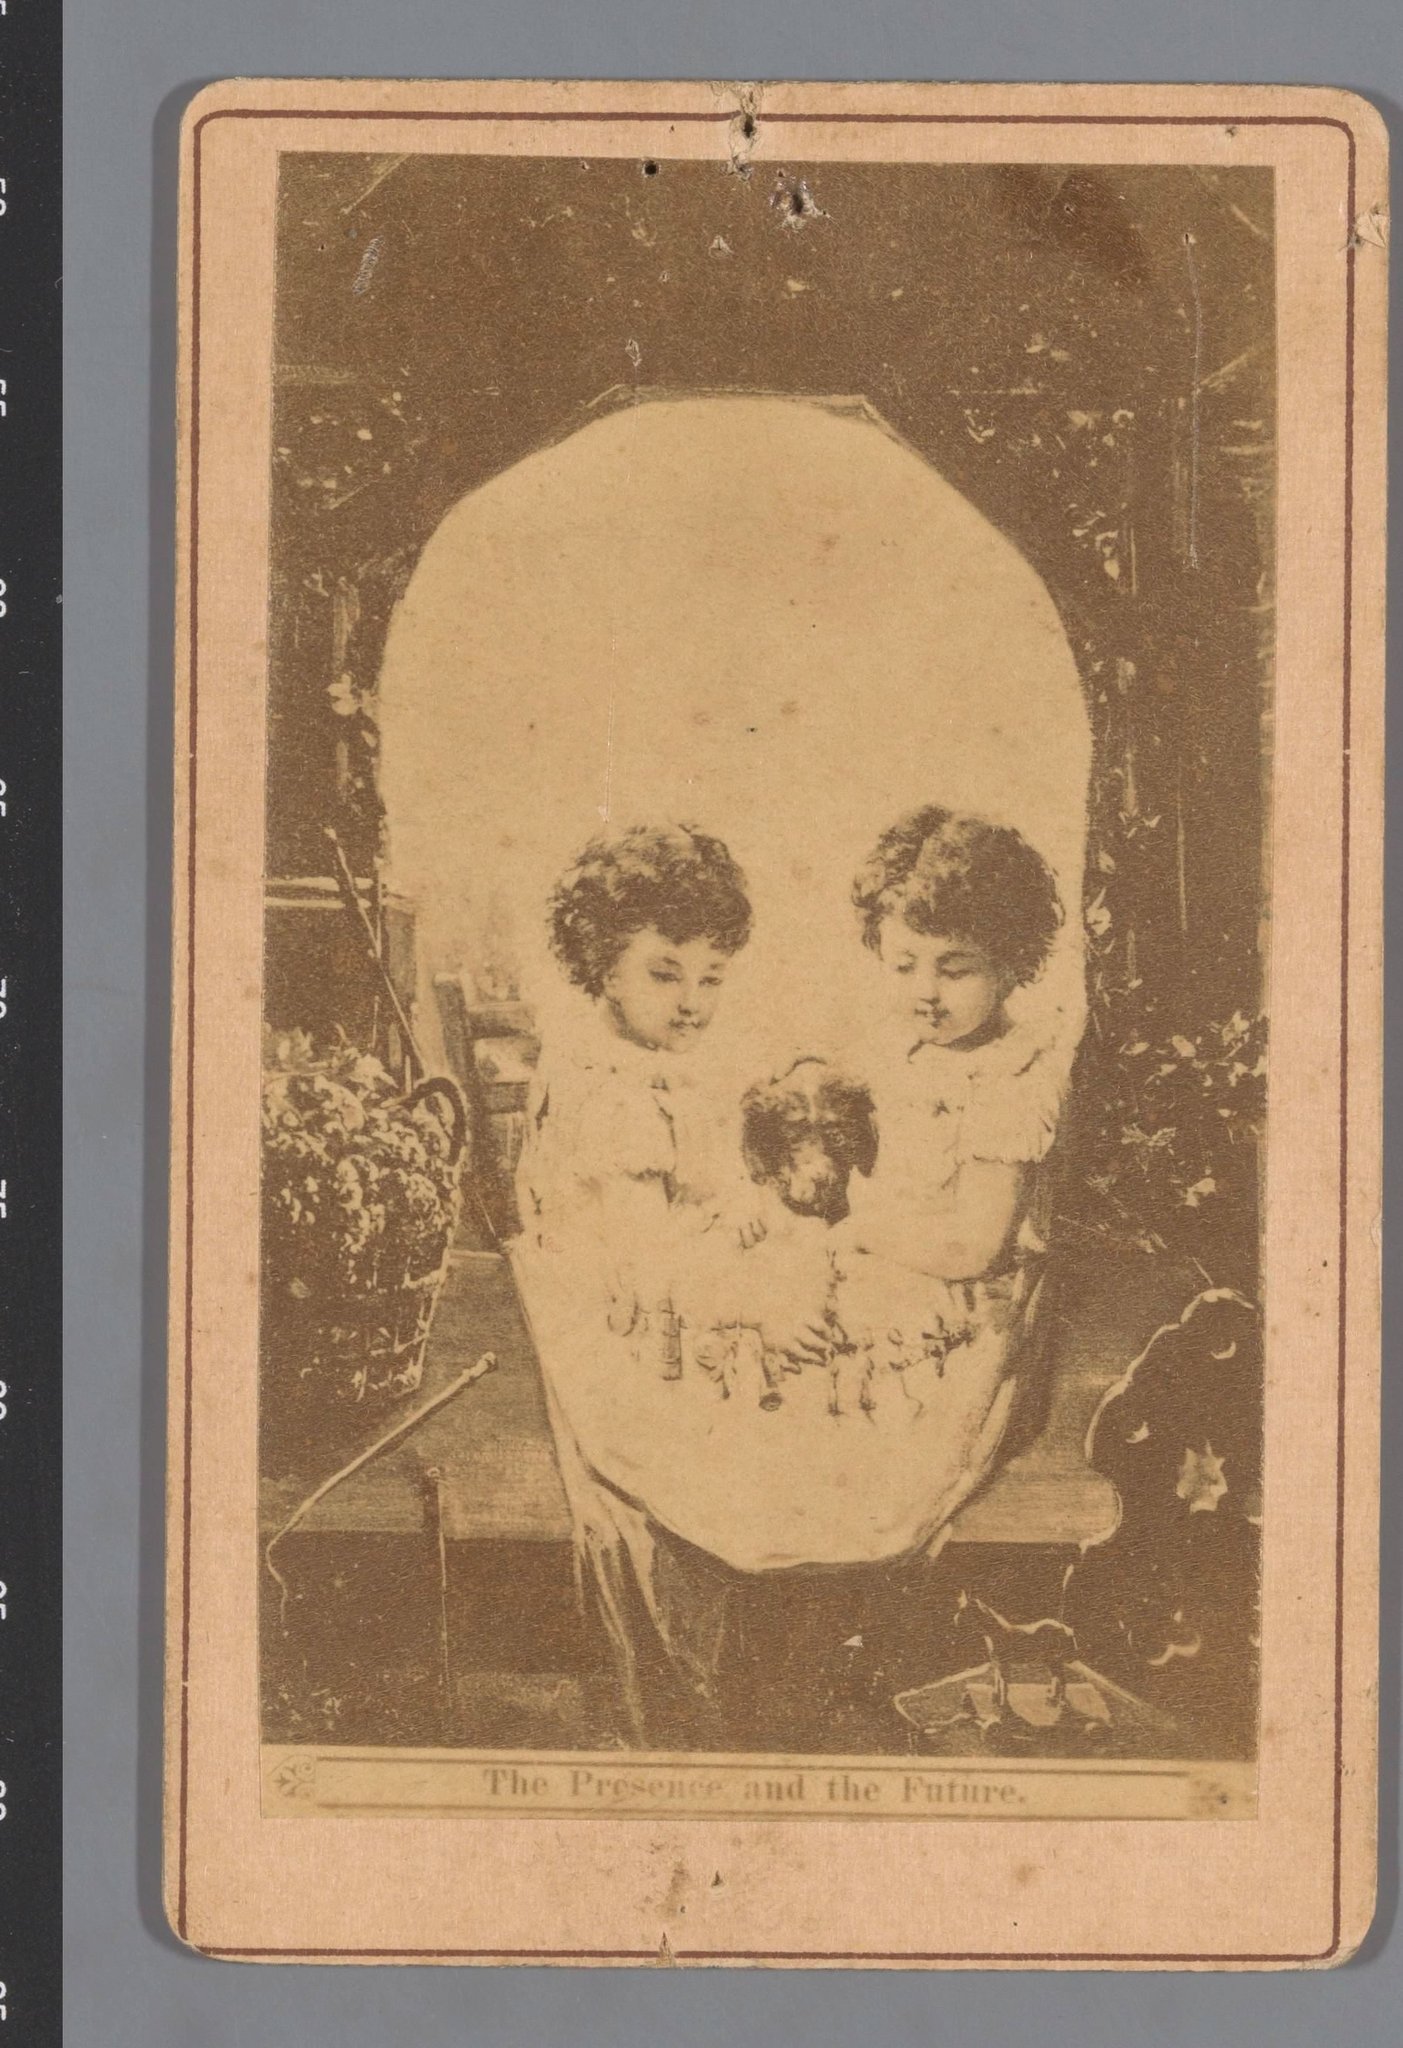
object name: photograph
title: Fotoreproductie van een ontwerp van twee kinderen en een hond die de ogen en neus vormen van een schedel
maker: Anonymous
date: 1870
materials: cardboard, photographic support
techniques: albumen print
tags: skull as symbol of 'vanitas', child playing with animals, death's head, skull (symbol of death)